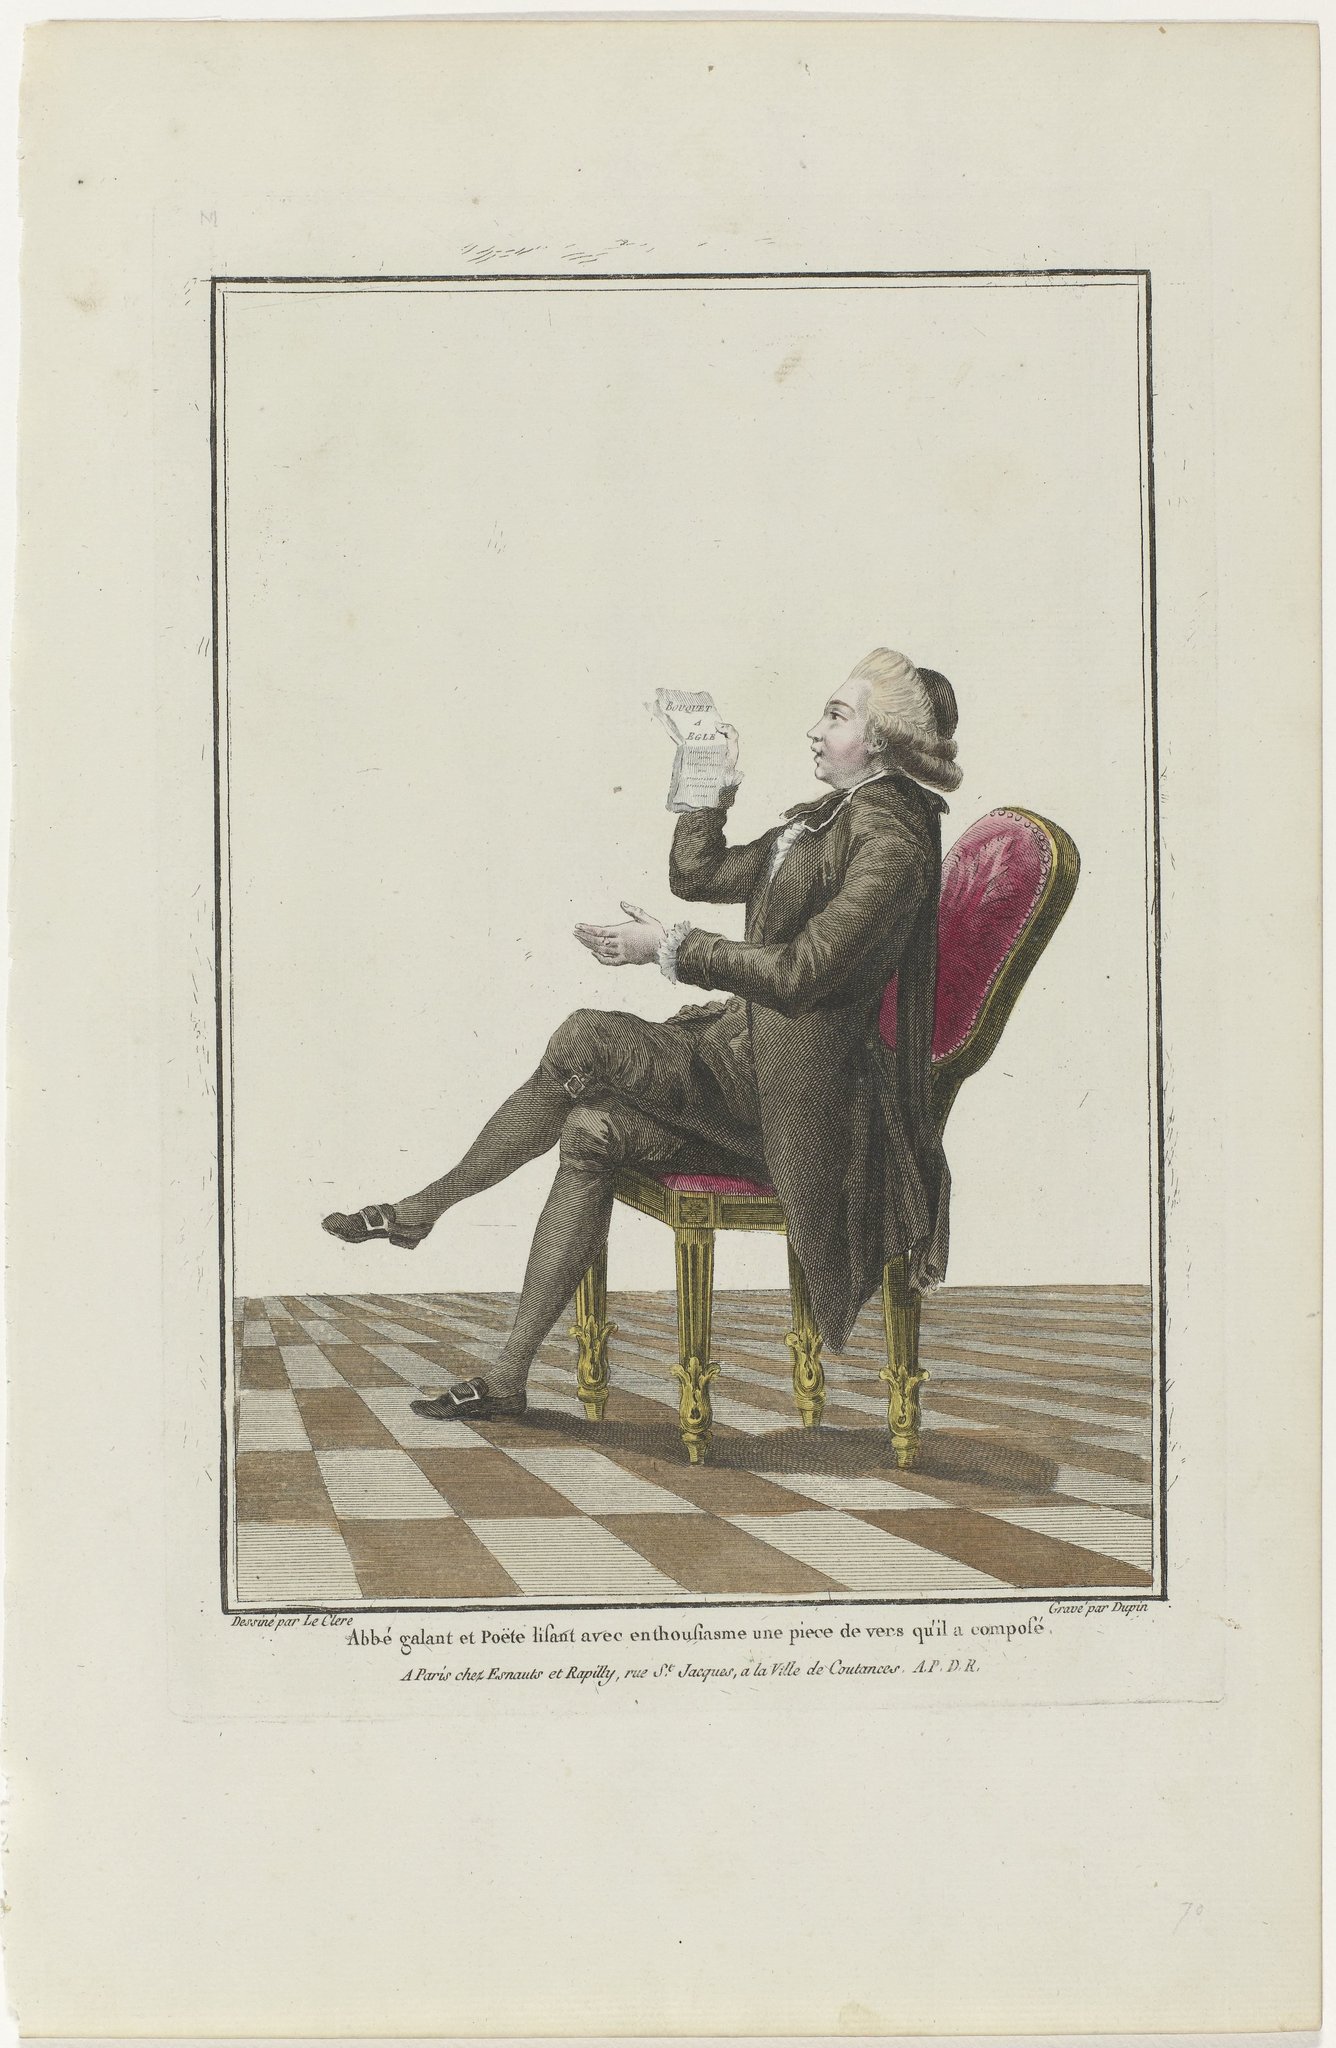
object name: fashion print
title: Gallerie des Modes et Costumes Français, 1778, M 70 : Abbé galant et Poëte lisant (...)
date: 1778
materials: paper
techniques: engraving, hand coloring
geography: paris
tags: ring (+ men's clothes), clothing for the upper part of the body (vest) (+ men's clothes), head-gear (kalot) (+ women's clothes), fashion plates, shoes, sandals (+ men's clothes), letter, envelope, chair, stockings, socks (+ men's clothes), sleeves (+ men's clothes), buckle (+ men's clothes), neck-gear ~ clothing (bands) (+ men's clothes)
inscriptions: caption: ‘Abbé galant et Poëte lisant avec enthousiasme une piece de vers qu'il a composé.’, inscription: ‘Bouquet a Eglé’, address: ‘A Paris chez Esnauts et Rapilly, rue St. Jacques, a la Ville de Coutances. A.P.D.R.’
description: Jonge elegante abt, zittend op een stoel, een zelfgeschreven gedicht lezend. Hij draagt een soutanelle en een vest op een kniebroek met bij de zoom een gesp. Om de hals een bef. Op het kapsel 'demi-grecque' ee kalot. Kousen en schoenen met gespen. Ring aan de vinger. Prent uit de serie M. 12e Cahier de Costumes Français, 6e Suite d'Habillemens à la mode en 1778, Gallerie des Modes et Costumes Français.